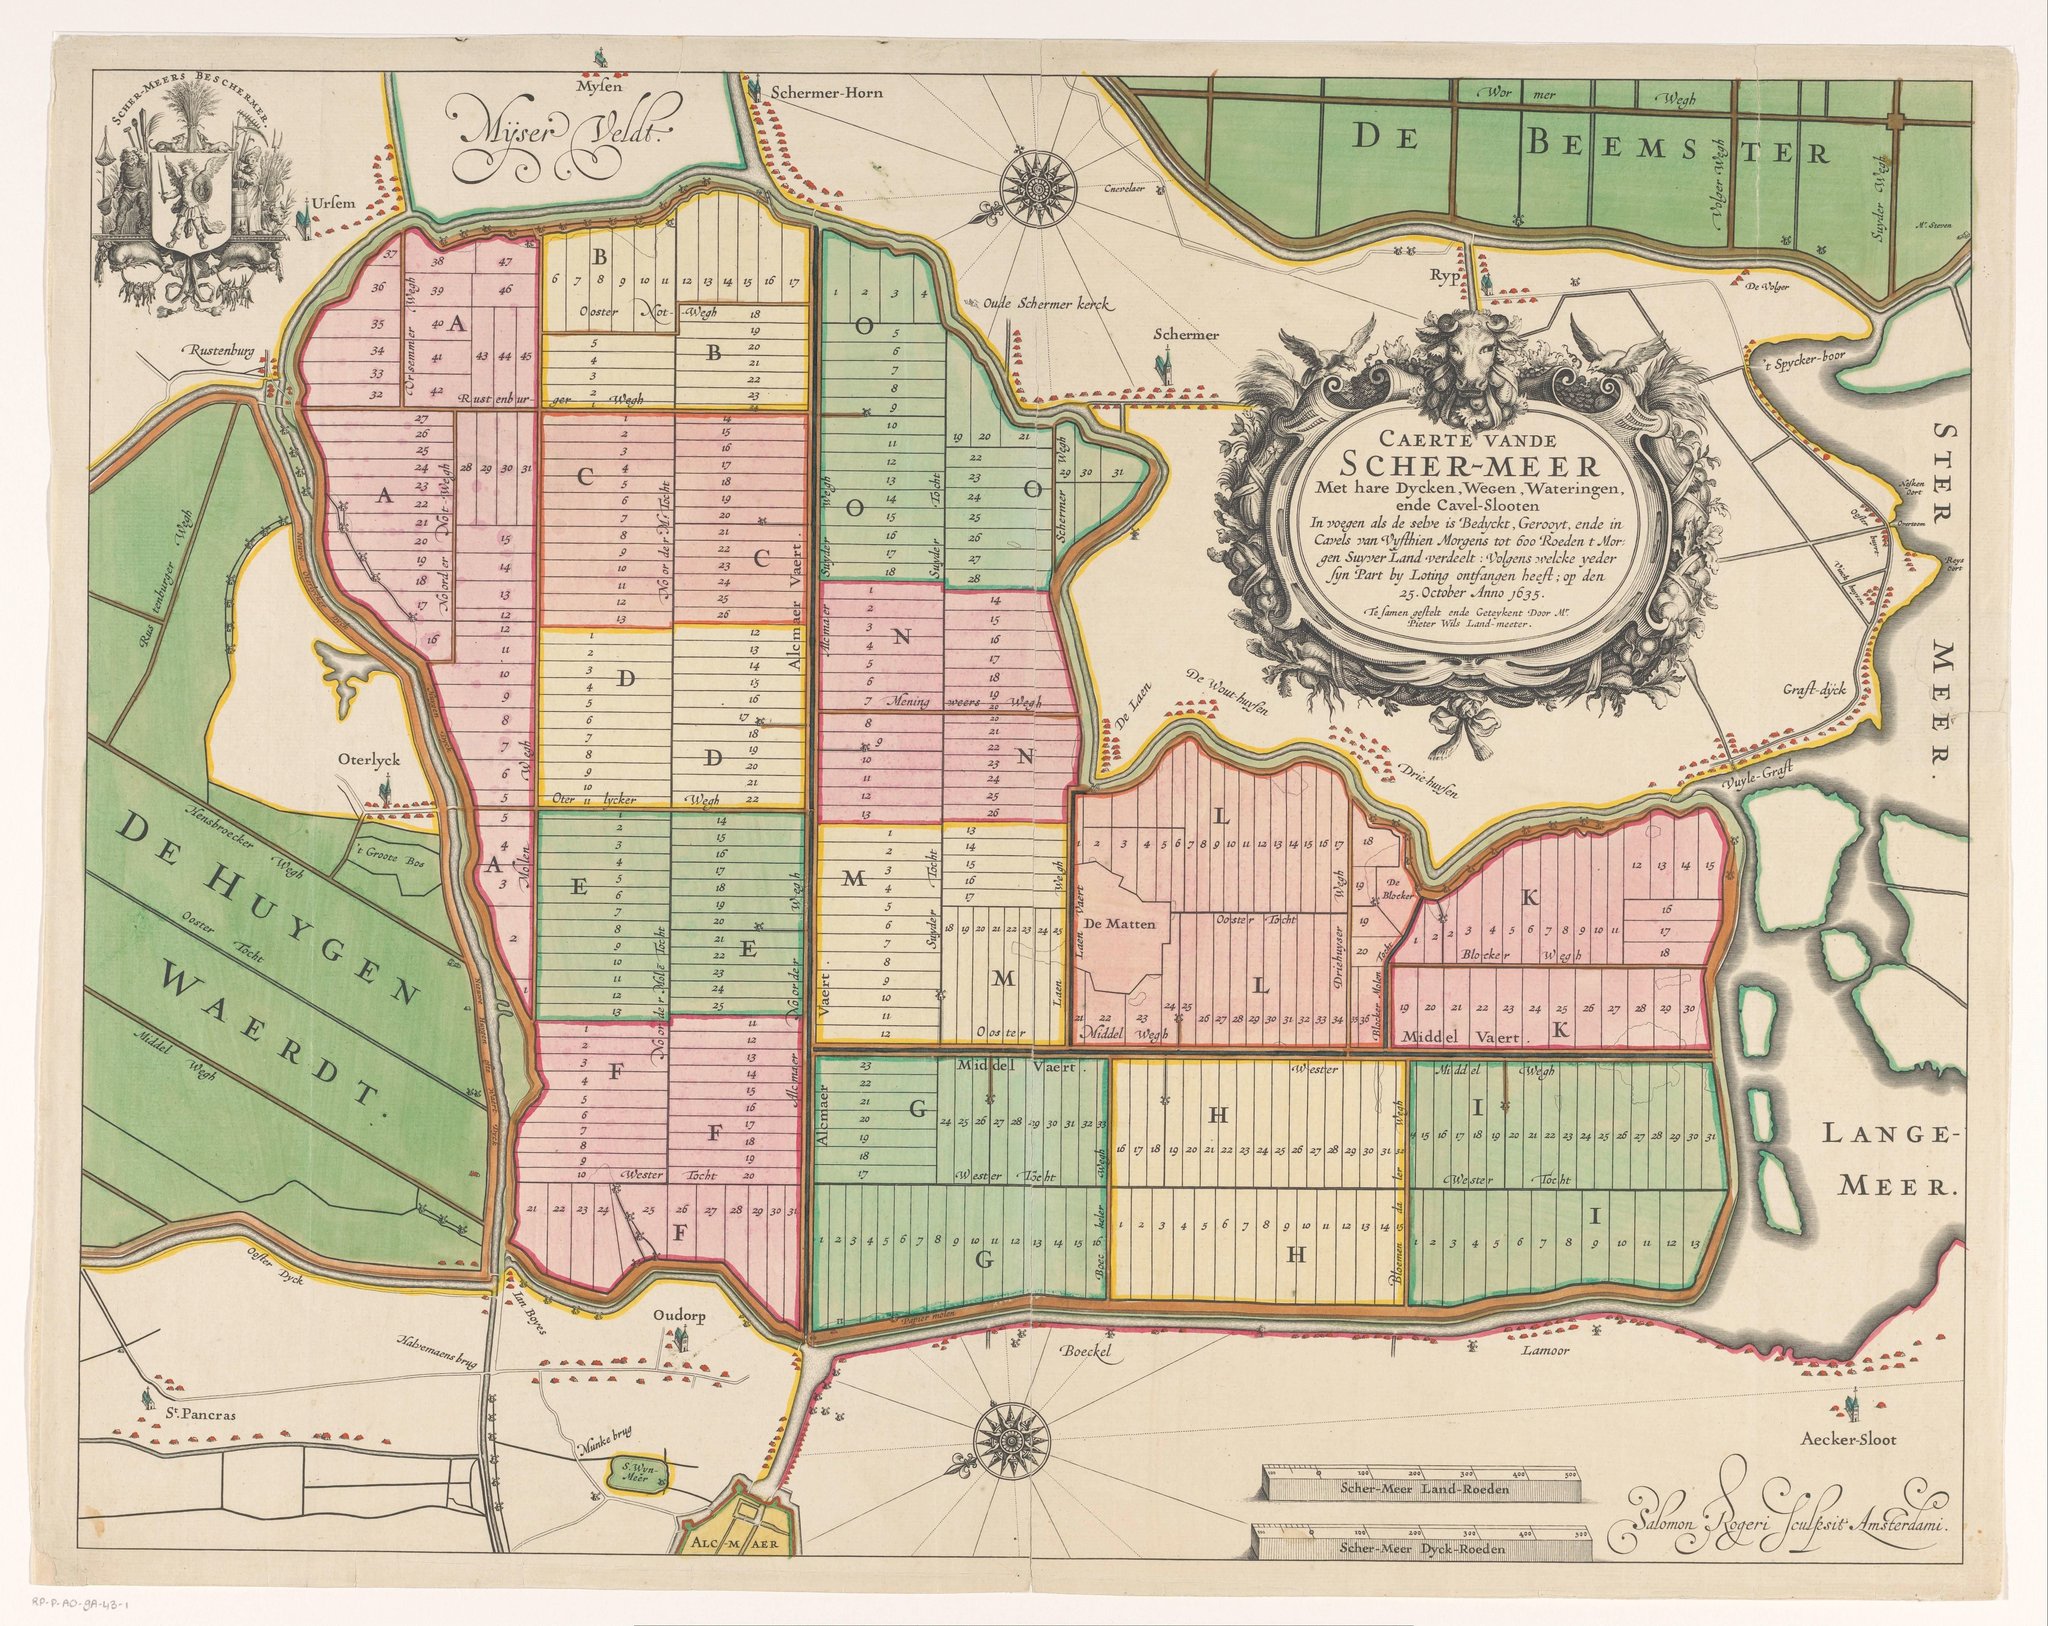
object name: map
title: Caerte vande Scher-meer met hare dycken, wegen, wateringen ende cavel-slooten …Volgens welcke yeder syn part by loting ontfangen heeft; op den 25. october anno 1635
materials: paper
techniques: engraving, hand coloring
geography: amsterdam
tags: coat of arms (as symbol of the state, etc.), maps of separate countries or regions, polder, reclaimed land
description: Kaart van de Schermerpolder na voltooiing van de bedijking en verloting van de kavels op 25 oktober 1635. Linksboven een wapen met een beschermengel: Scher-meers Beschermer (mogelijk het toenmalige wapen van de polder). Rechtsboven de titelcartouche. Rechtsonder twee schaalstokken: 500 Scher-Meer land-roeden; 500 Scher-Meer dyck-roeden.